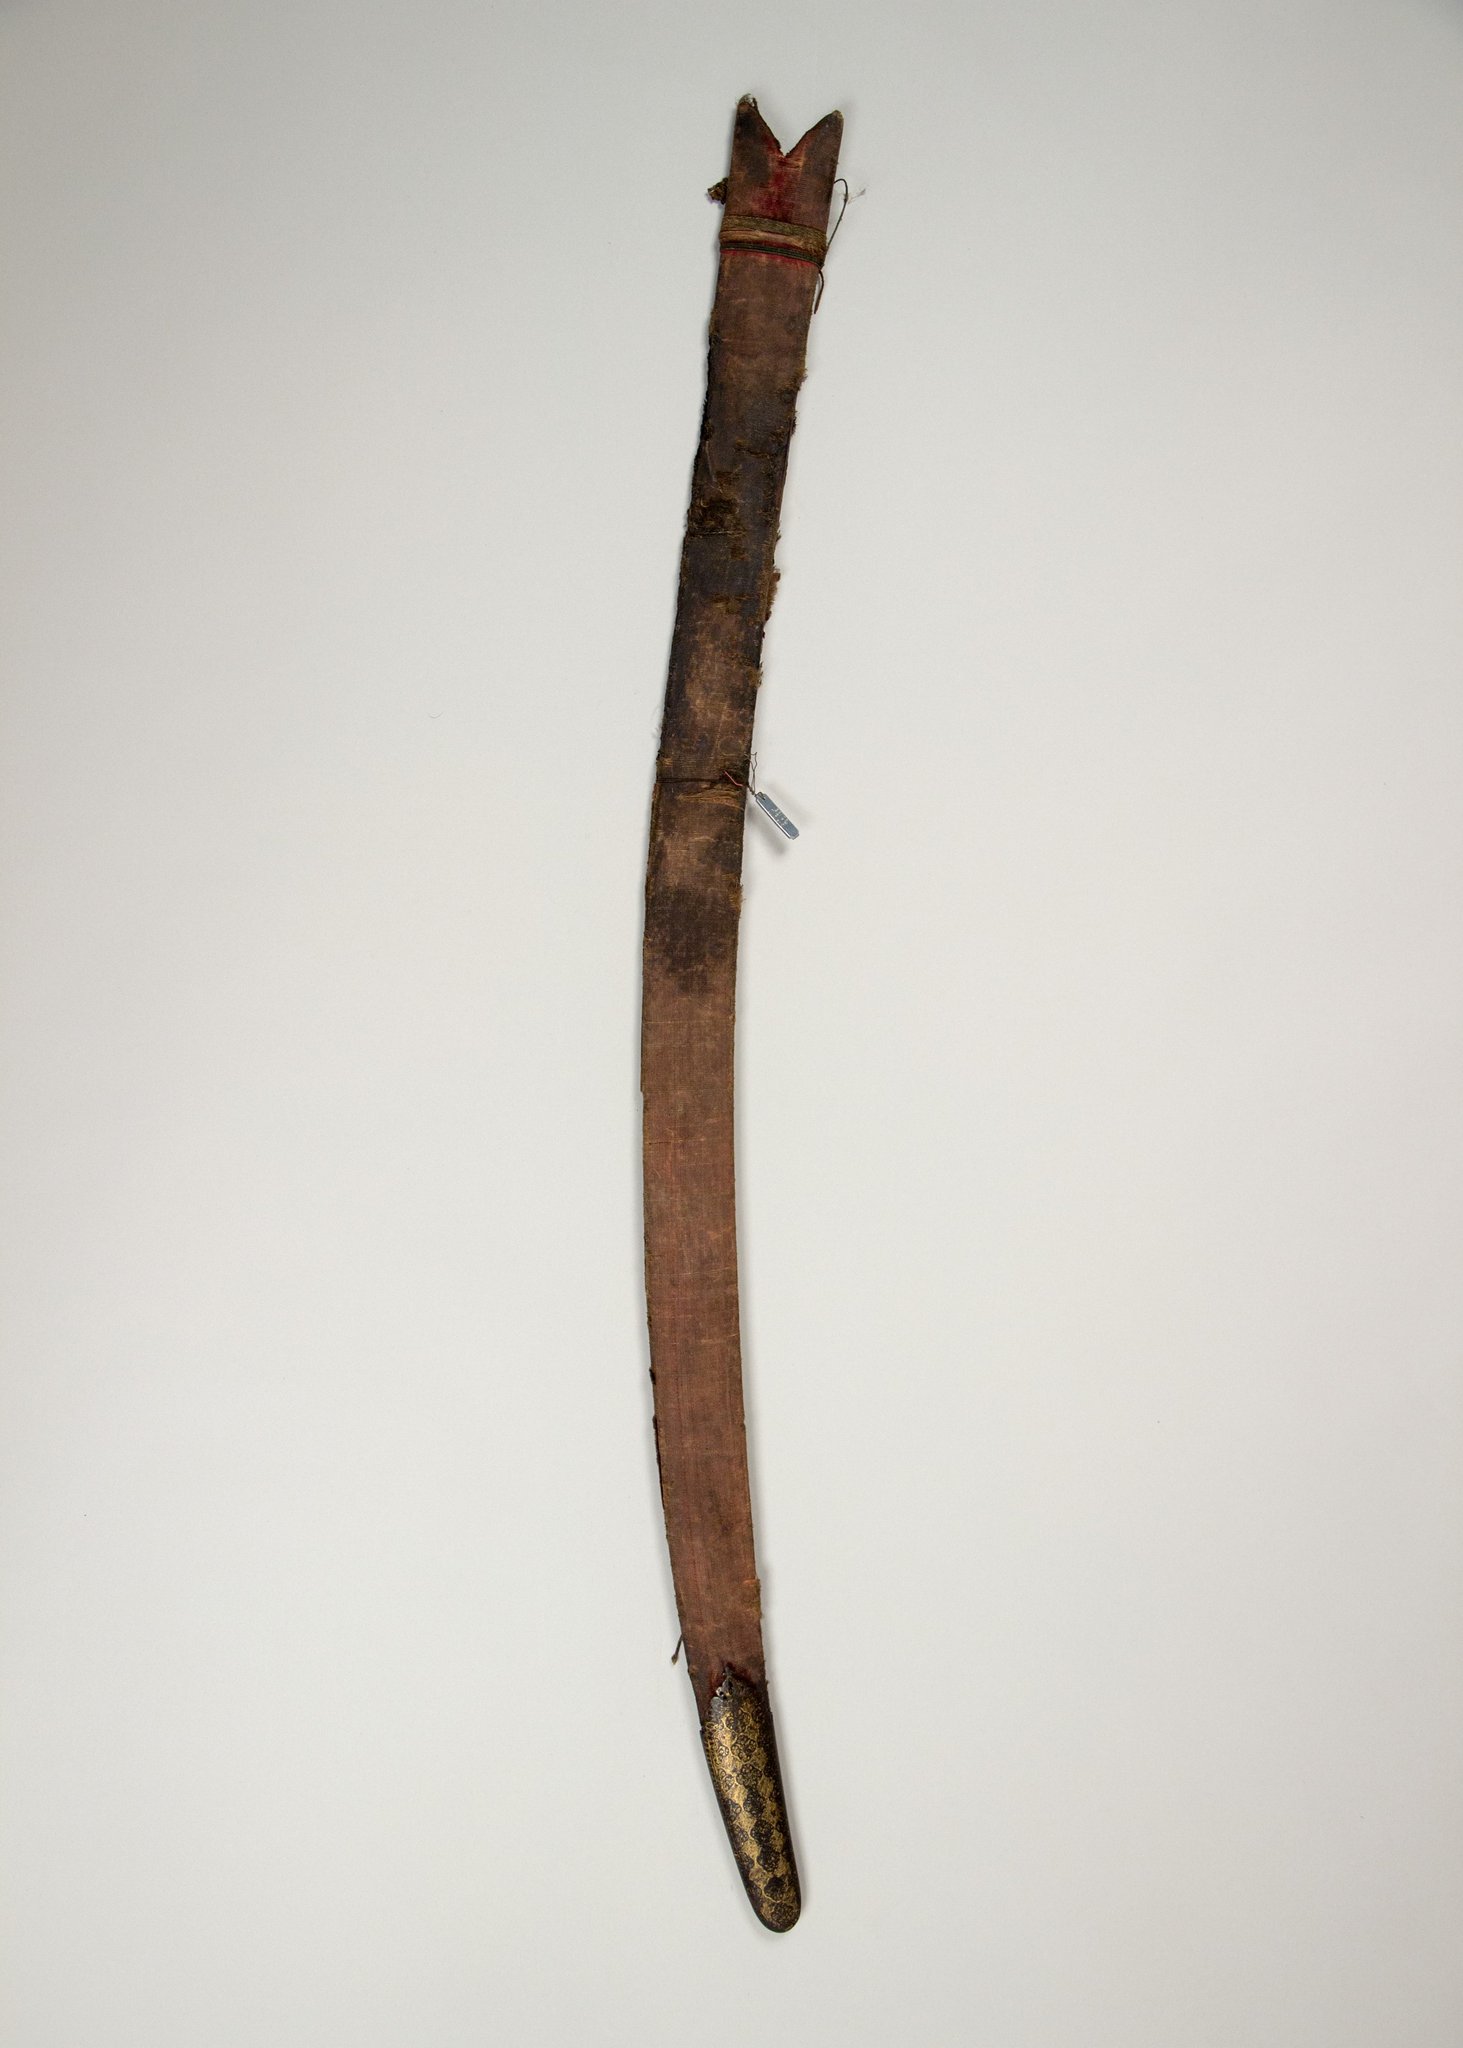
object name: sword with scabbard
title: Sword Scabbard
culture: persian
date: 1701-1900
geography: iran